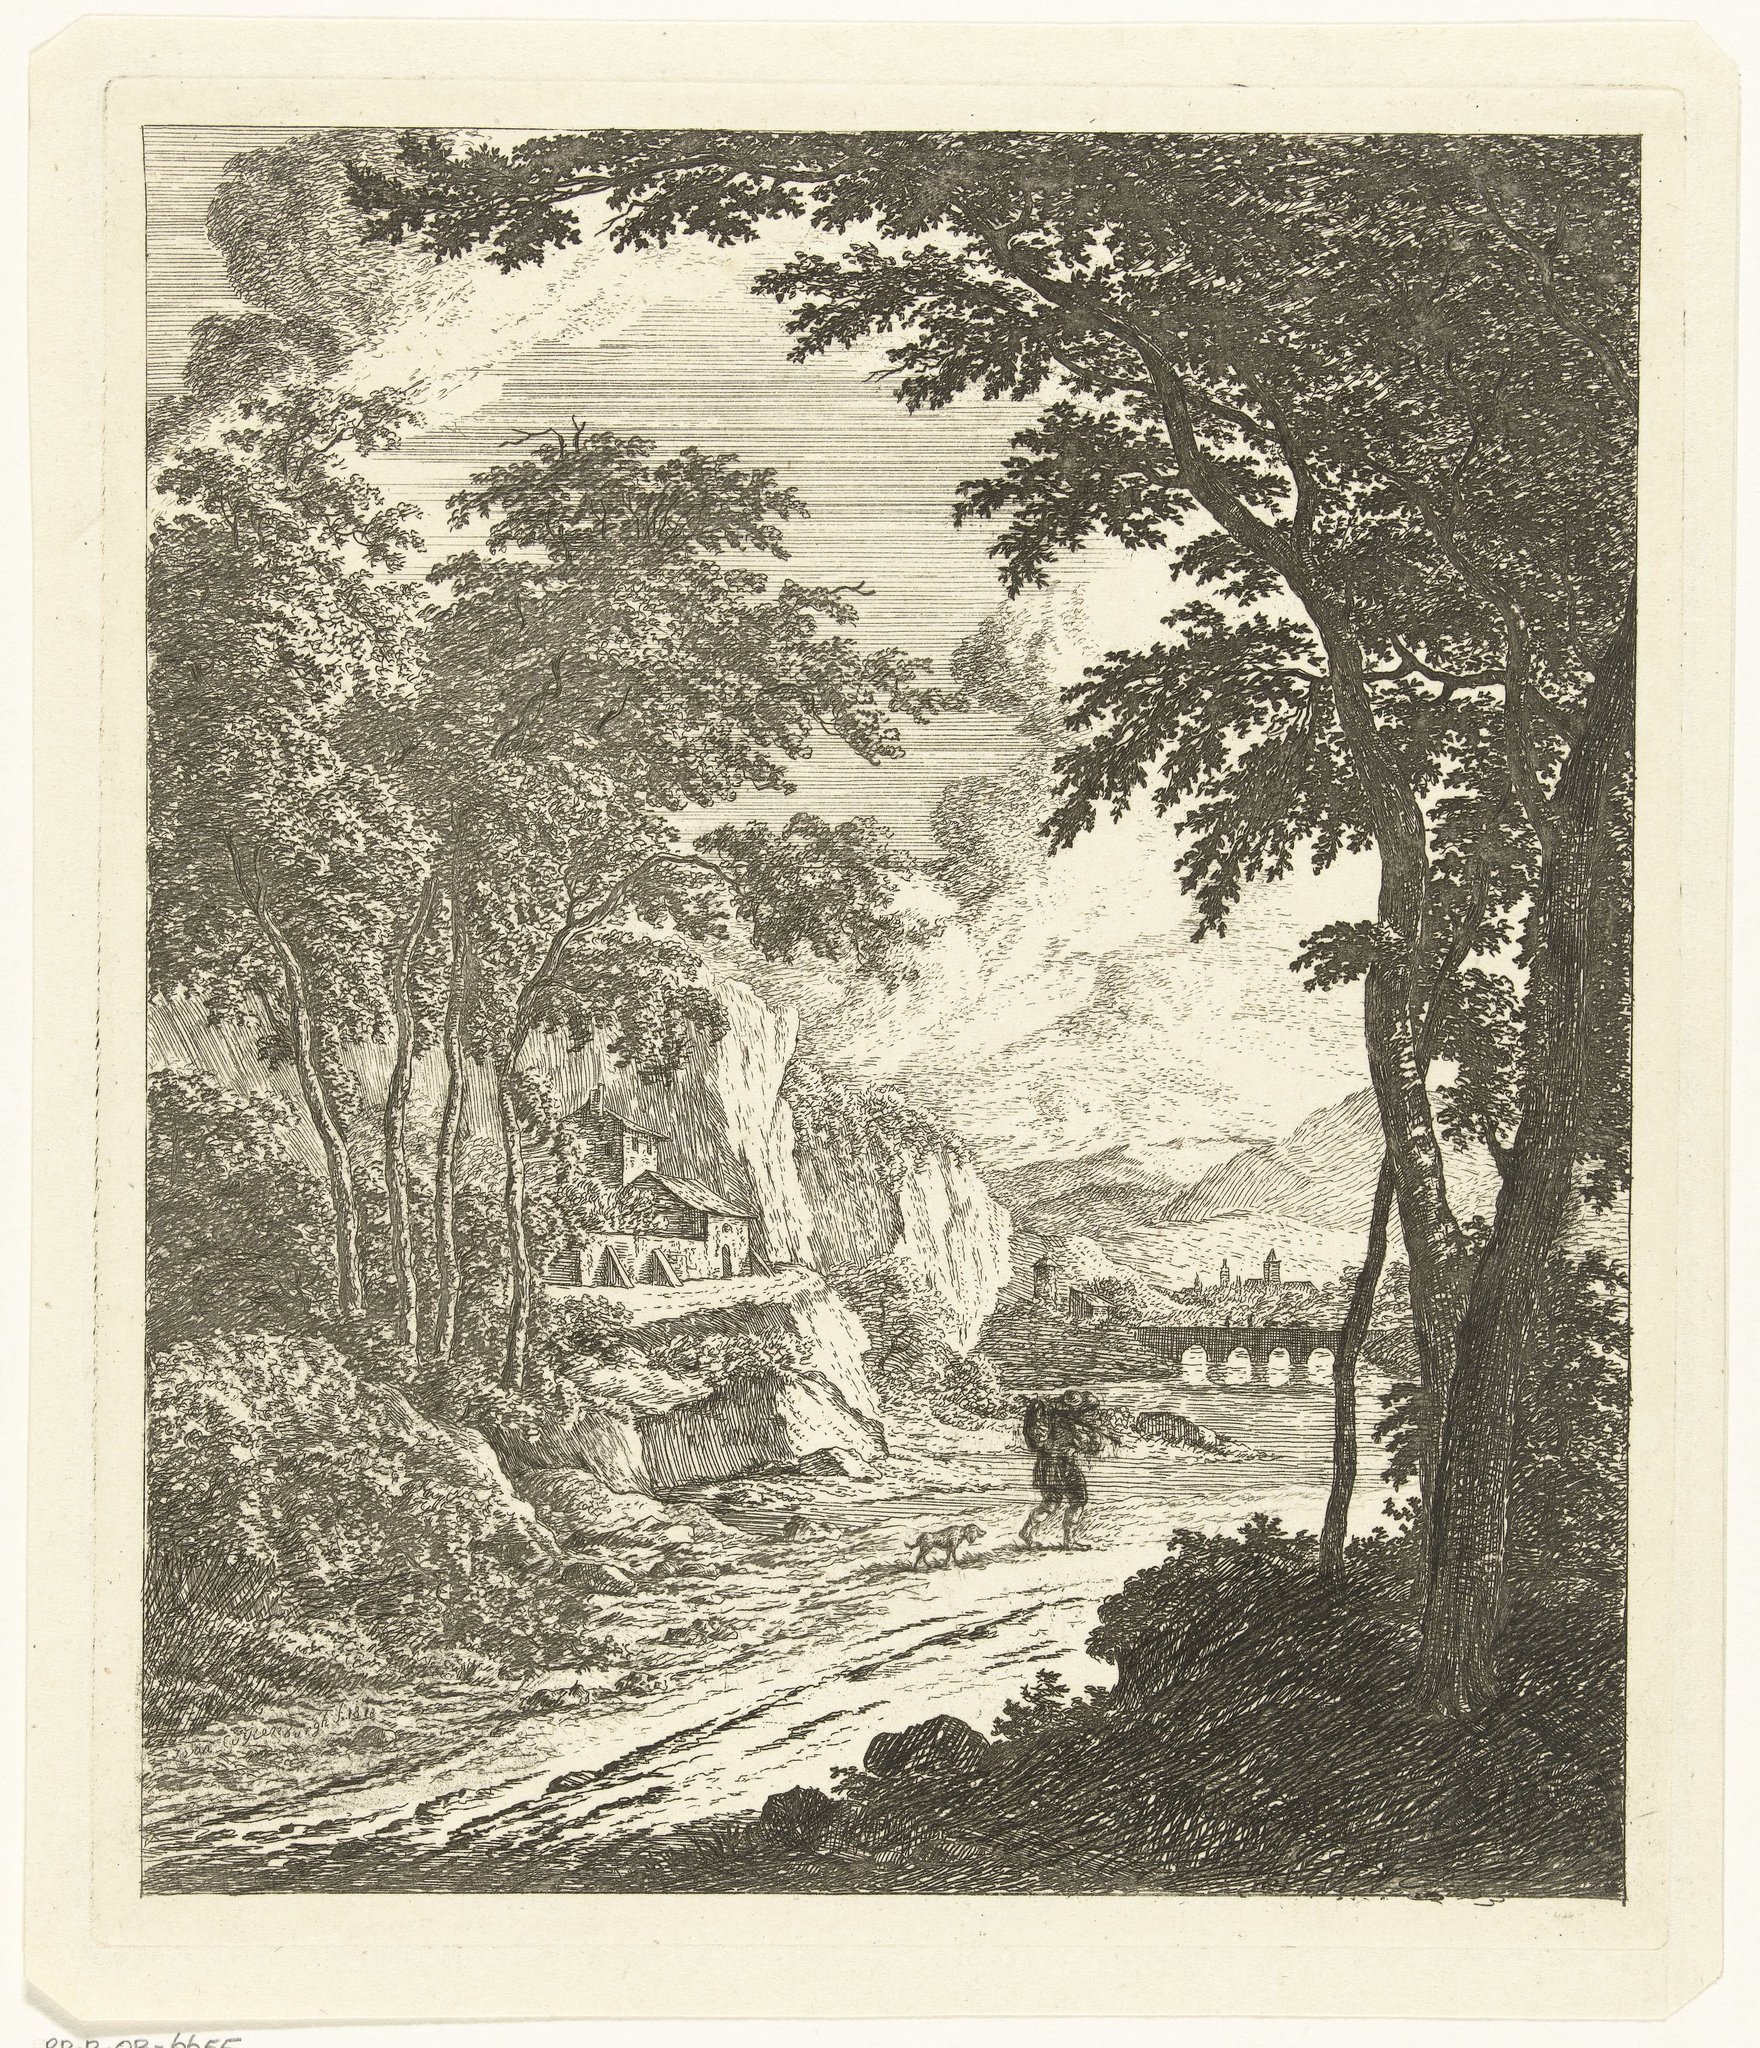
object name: print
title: Landschap met rivier en man met hond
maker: johannes van cuylenburgh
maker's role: print maker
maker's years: 1793-1841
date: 1818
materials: paper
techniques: etching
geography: netherlands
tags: (high) hill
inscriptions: collector's mark: Lugt 2228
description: Dit landschap is geïnspireerd door een prent van Jan Both.